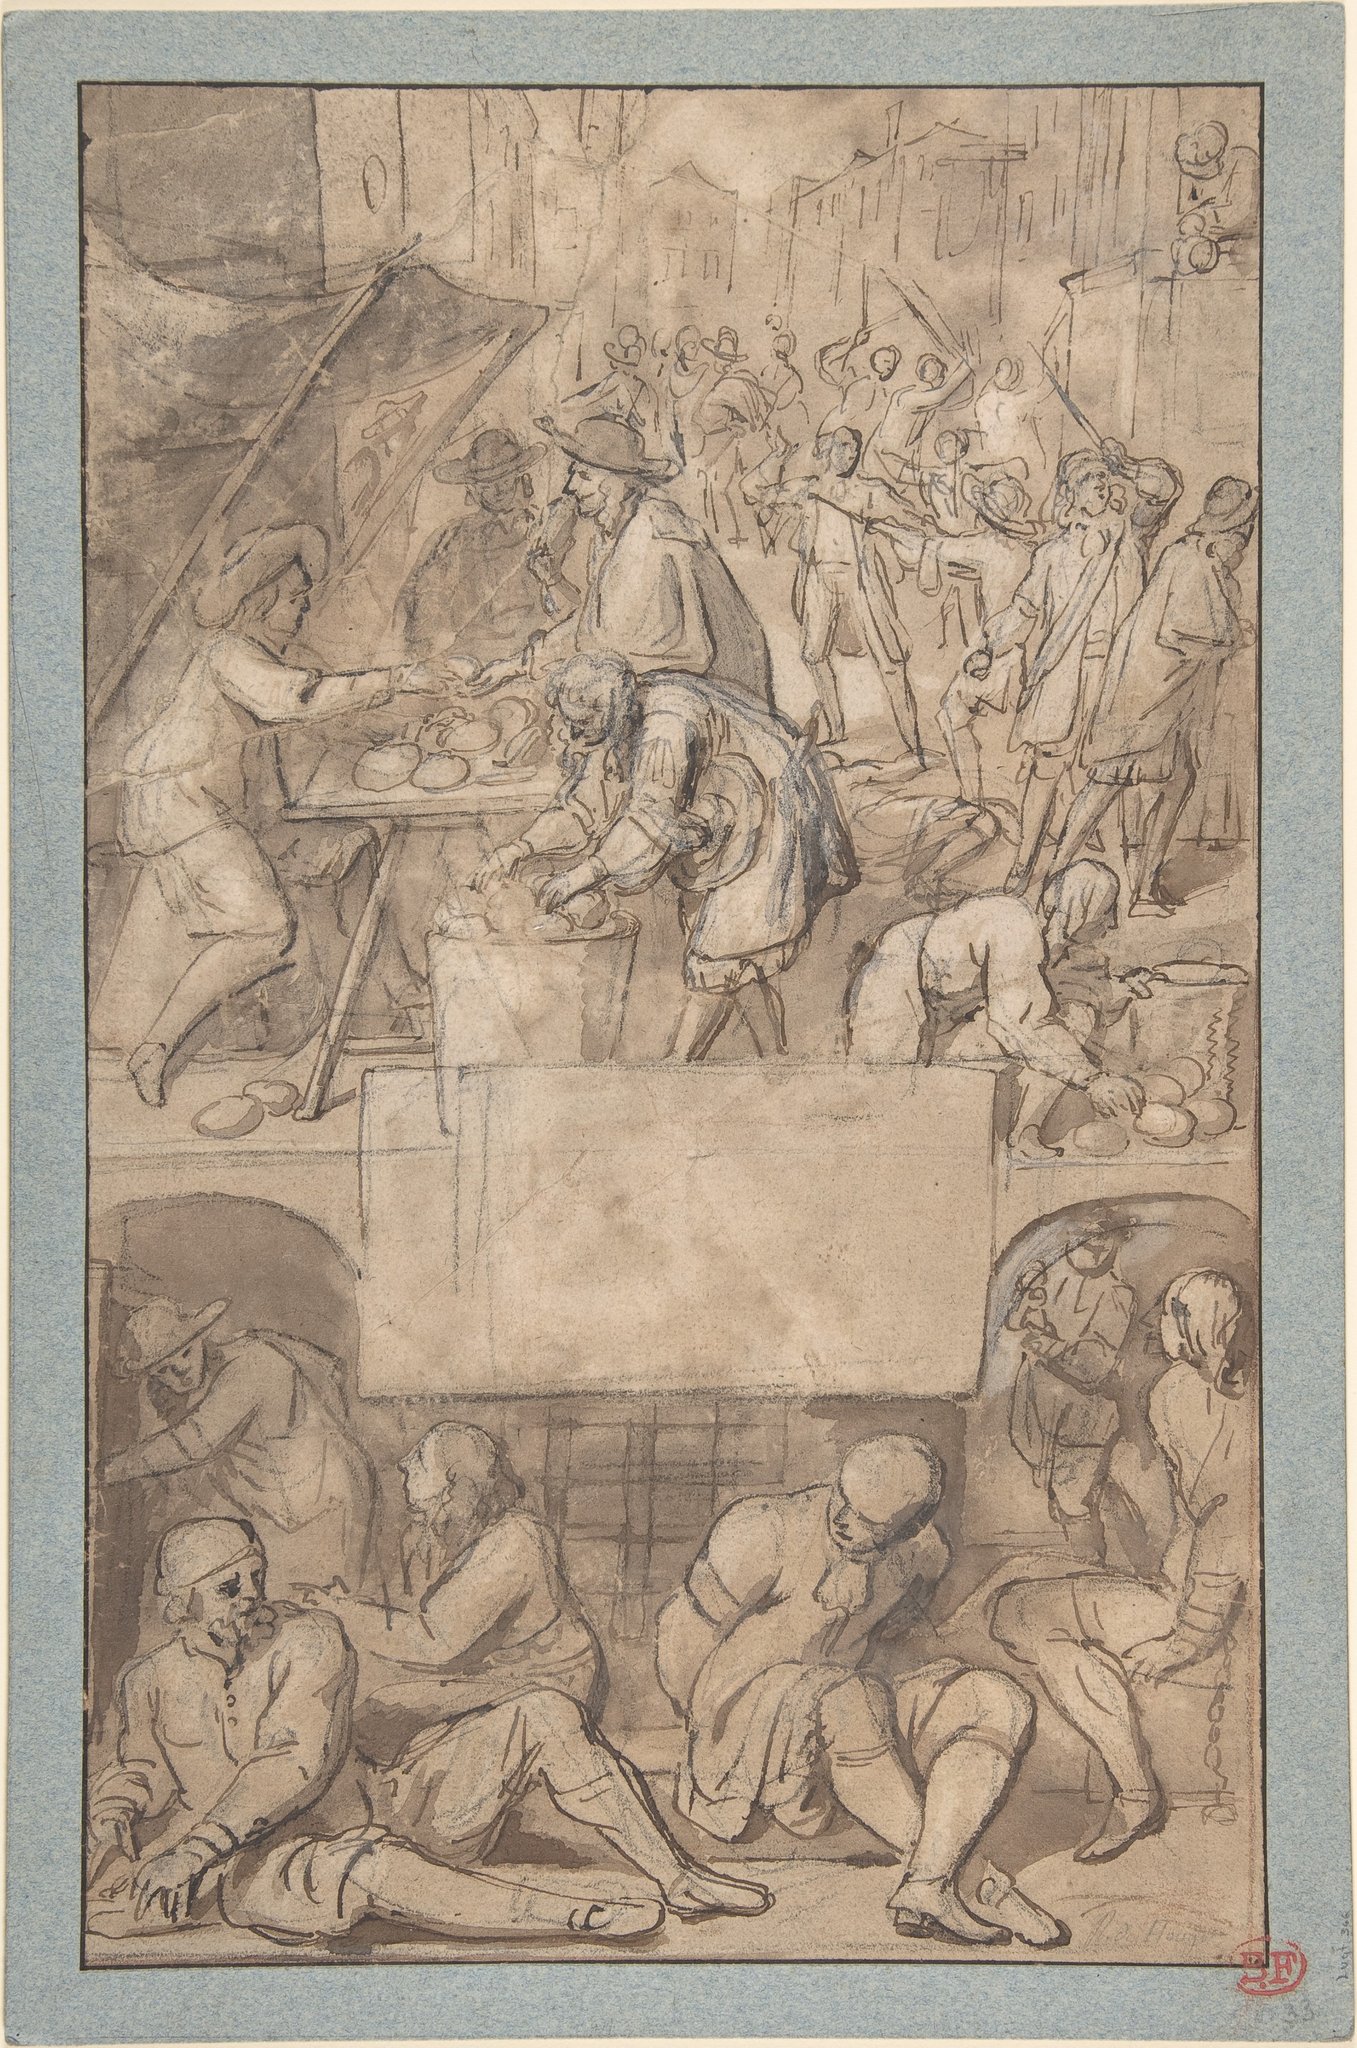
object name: drawing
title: Study for a Title-Page: Allegory of Commerce and a Debtor's Prison (?)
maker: romeyn de hooghe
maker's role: artist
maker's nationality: dutch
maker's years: 1645-1708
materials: chalk, gouache, ink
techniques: brush, pen, wash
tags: prisons,prisoners,men